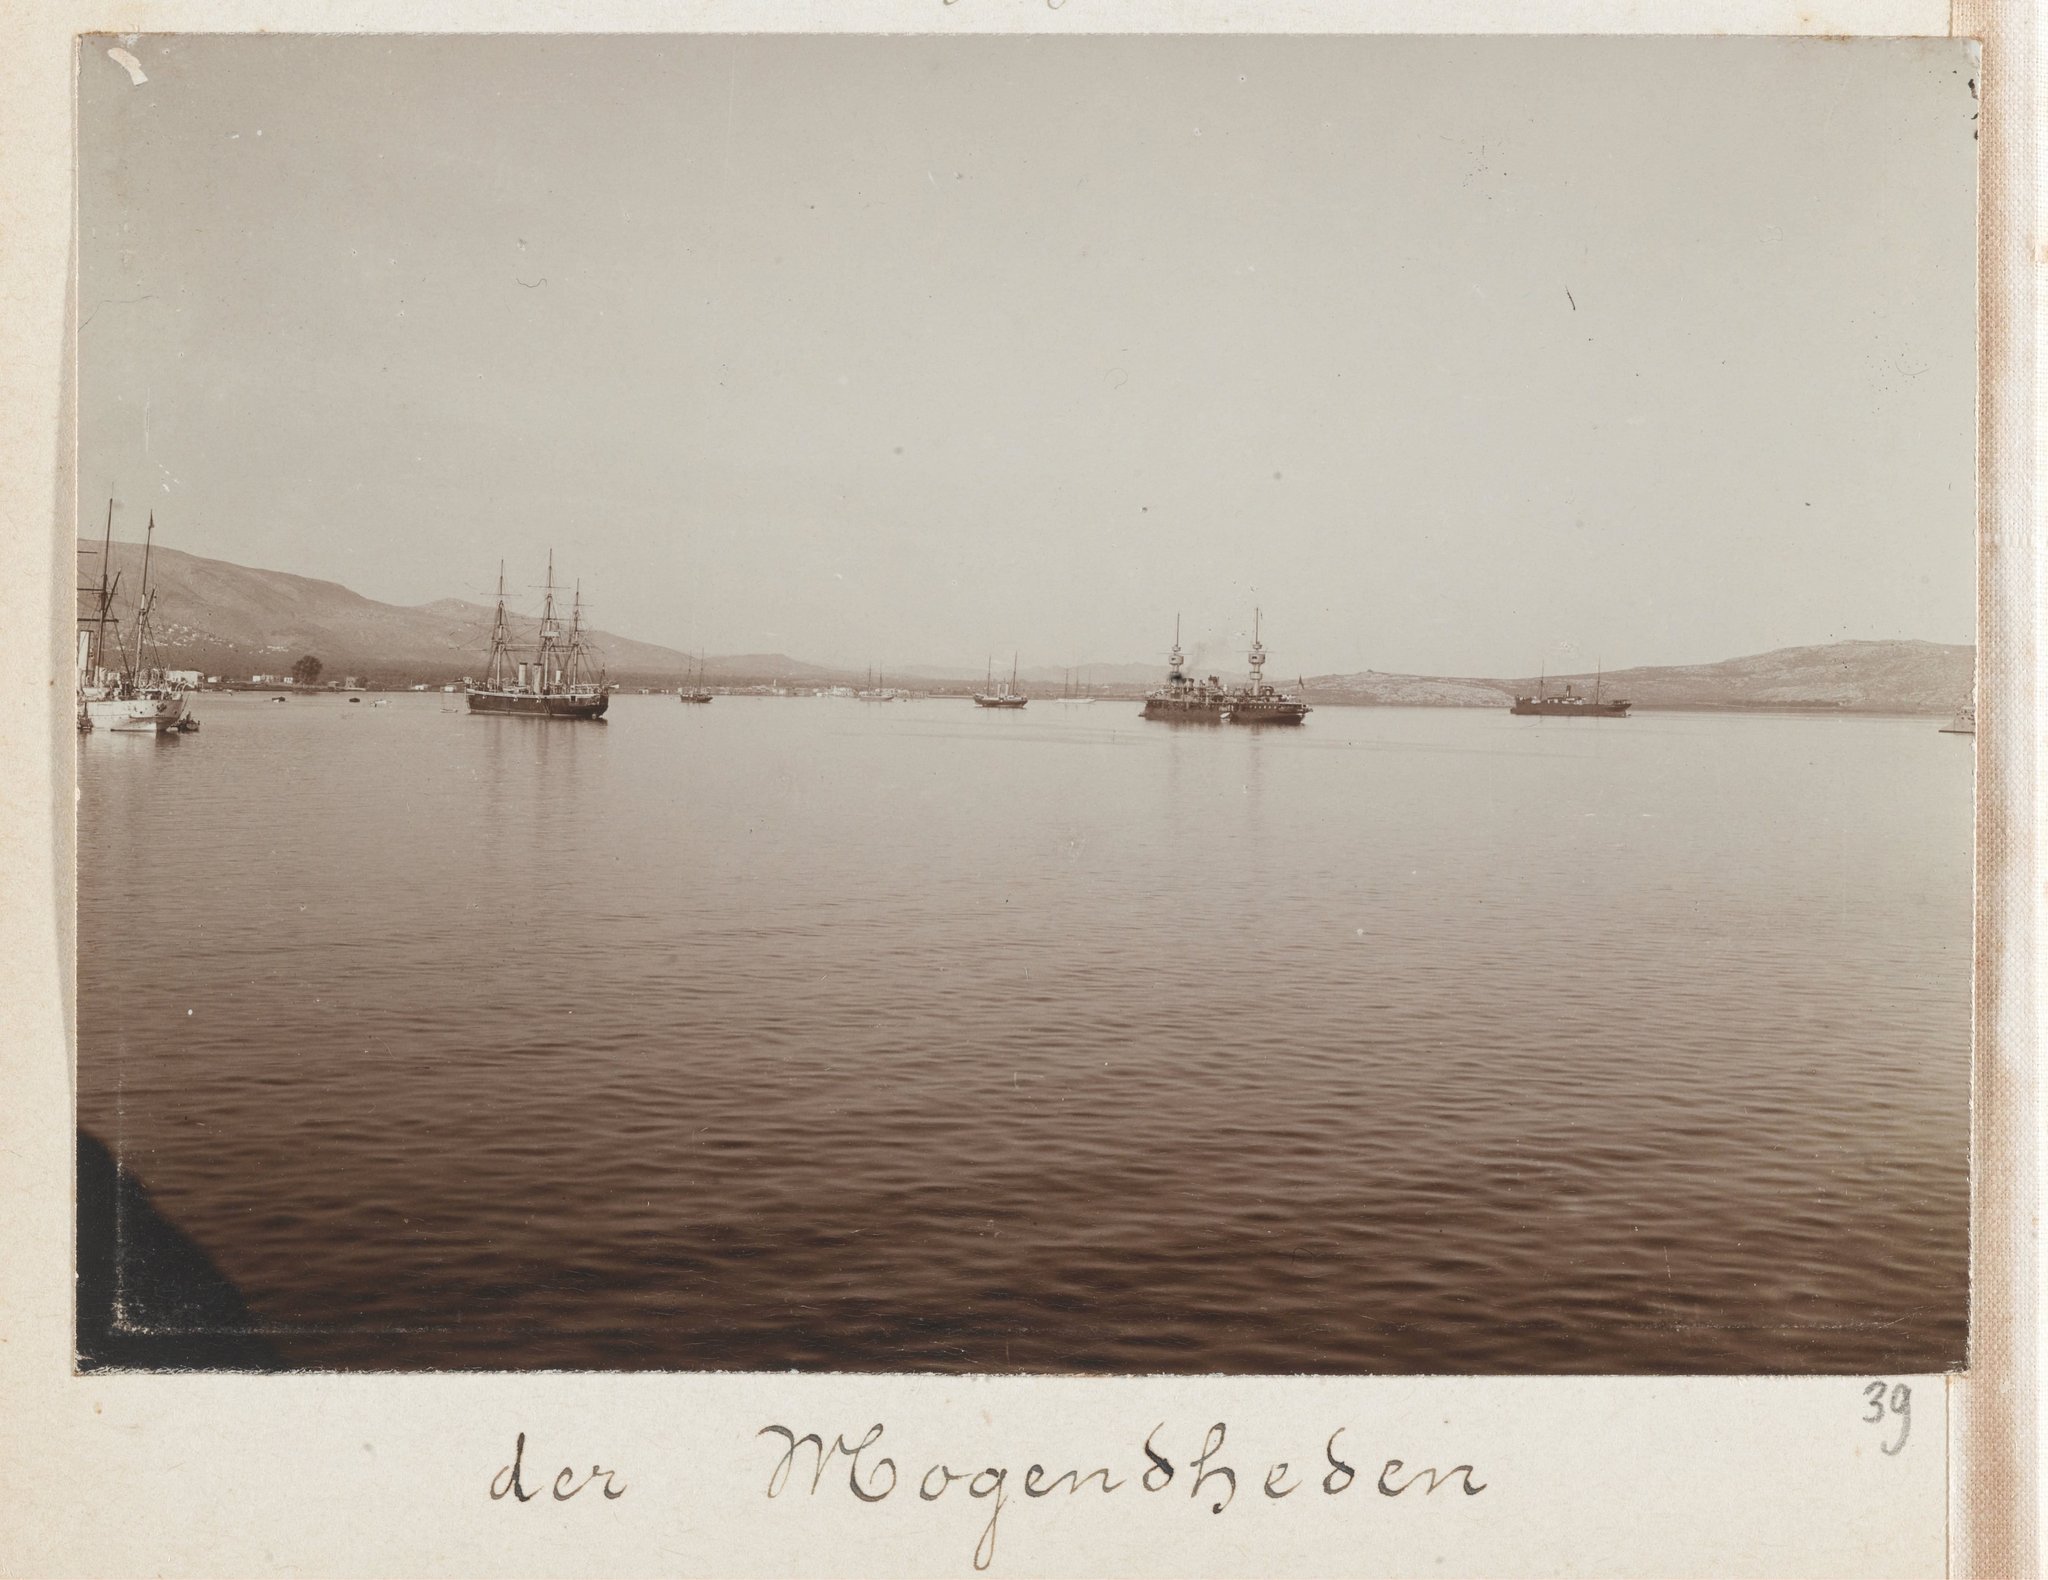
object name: photograph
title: Oorlogsschepen in de baai van Souda op Kreta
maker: johannes lodewijk heldring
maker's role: fotograaf, predikant, schrijver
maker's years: 1852-1923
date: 1898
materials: paper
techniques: collodion silver print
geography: creta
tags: navy (+ sailing-ships)